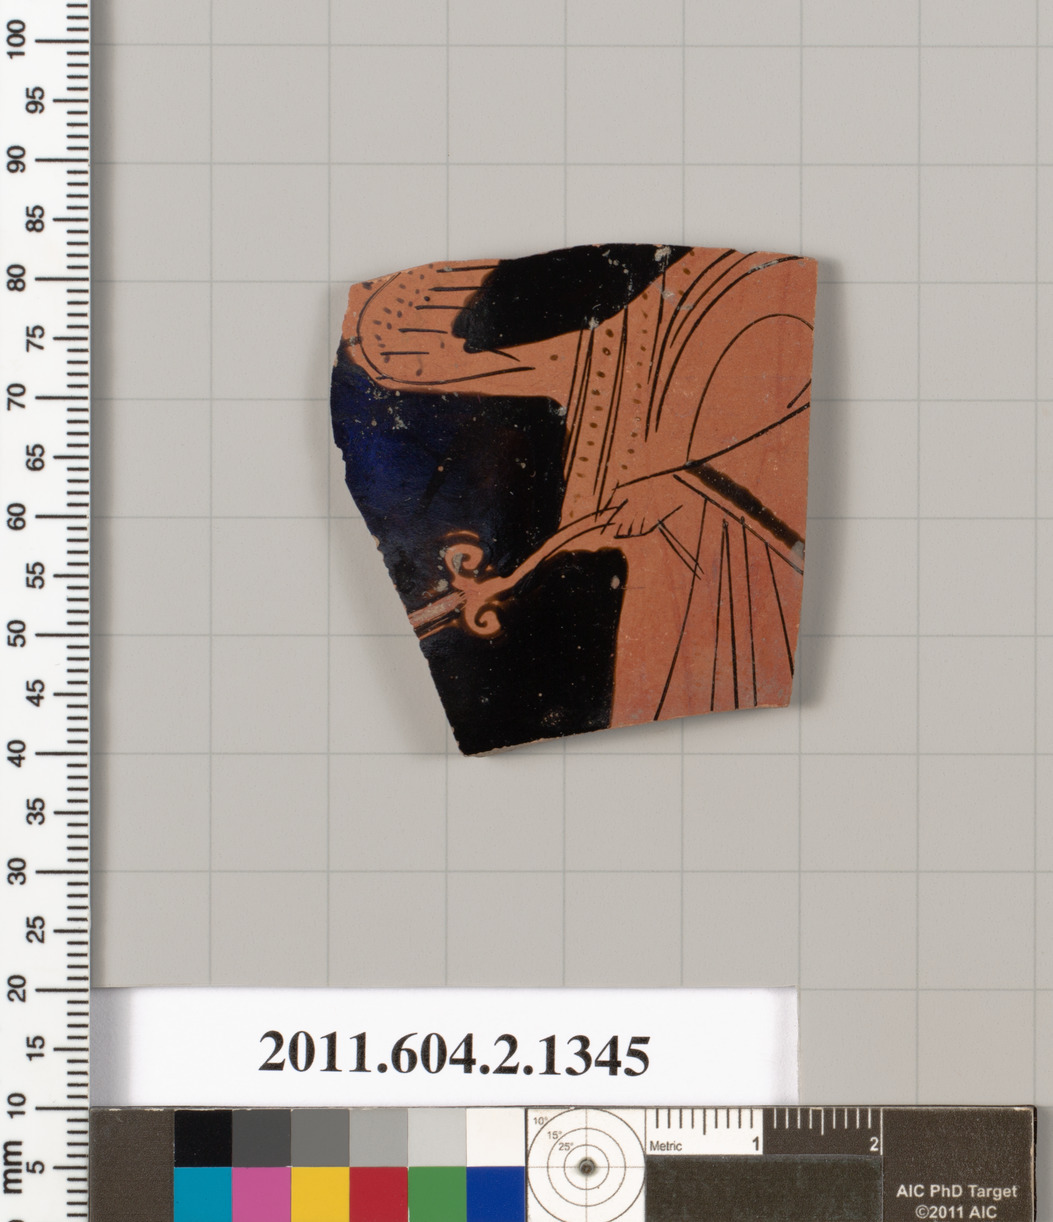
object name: skyphos fragment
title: Terracotta fragment of a skyphos (deep drinking cup)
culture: greek, attic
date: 460-440 BCE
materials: terracotta